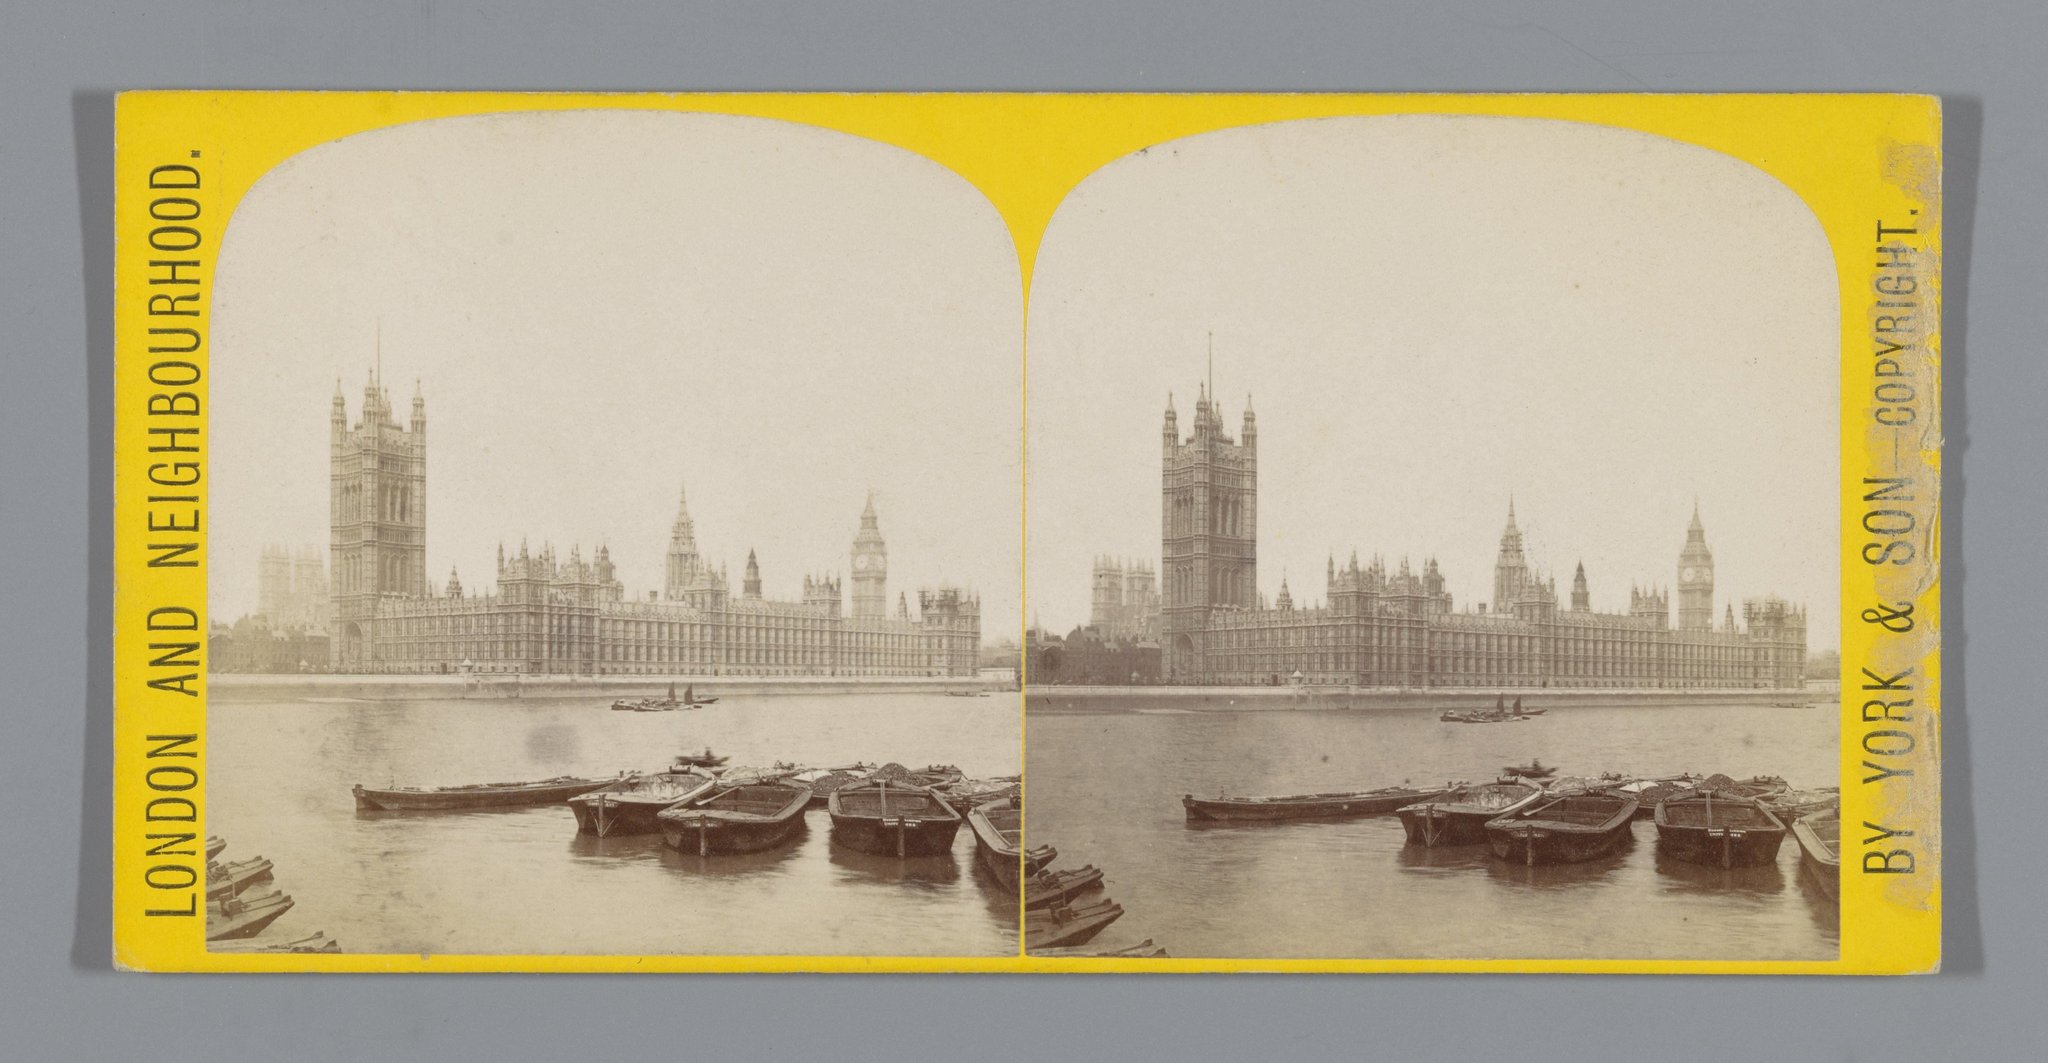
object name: stereograph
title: London and Neighbourhood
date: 1860-1880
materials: cardboard, photographic support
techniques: albumen print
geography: london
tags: river, lower house, parliament, chamber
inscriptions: number: ‘No. 96.’